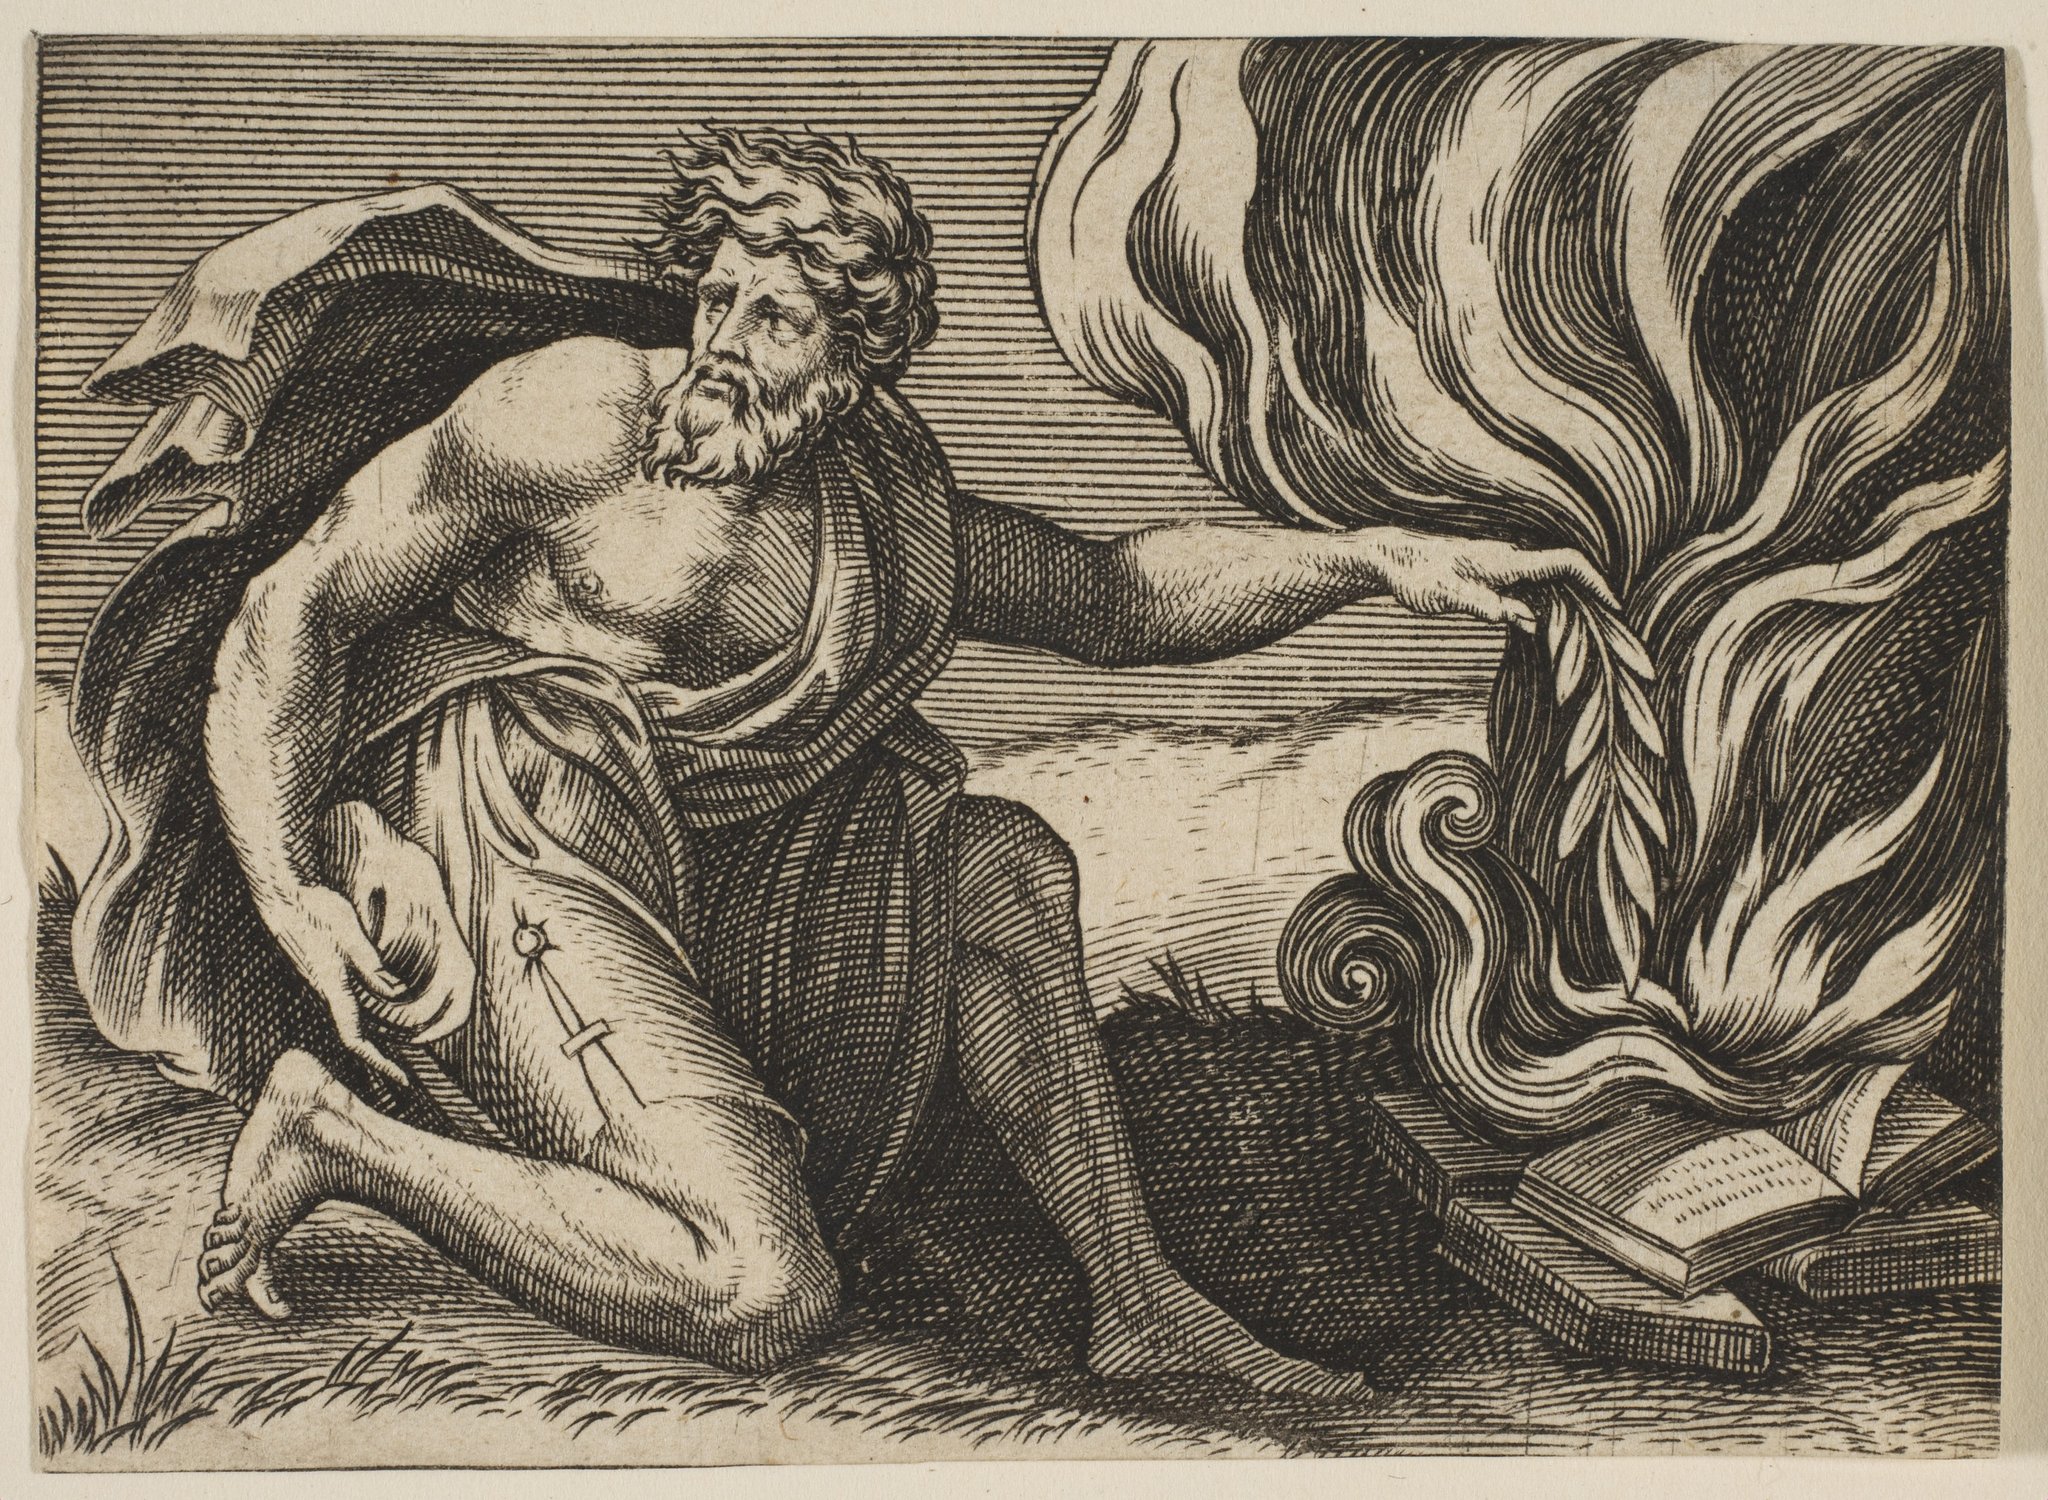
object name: print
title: A man kneeling and placing a laurel branch upon a pile of burning books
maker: marco dente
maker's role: artist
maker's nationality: italian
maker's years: 1515-1527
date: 1515-1527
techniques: engraving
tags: books,men,fire